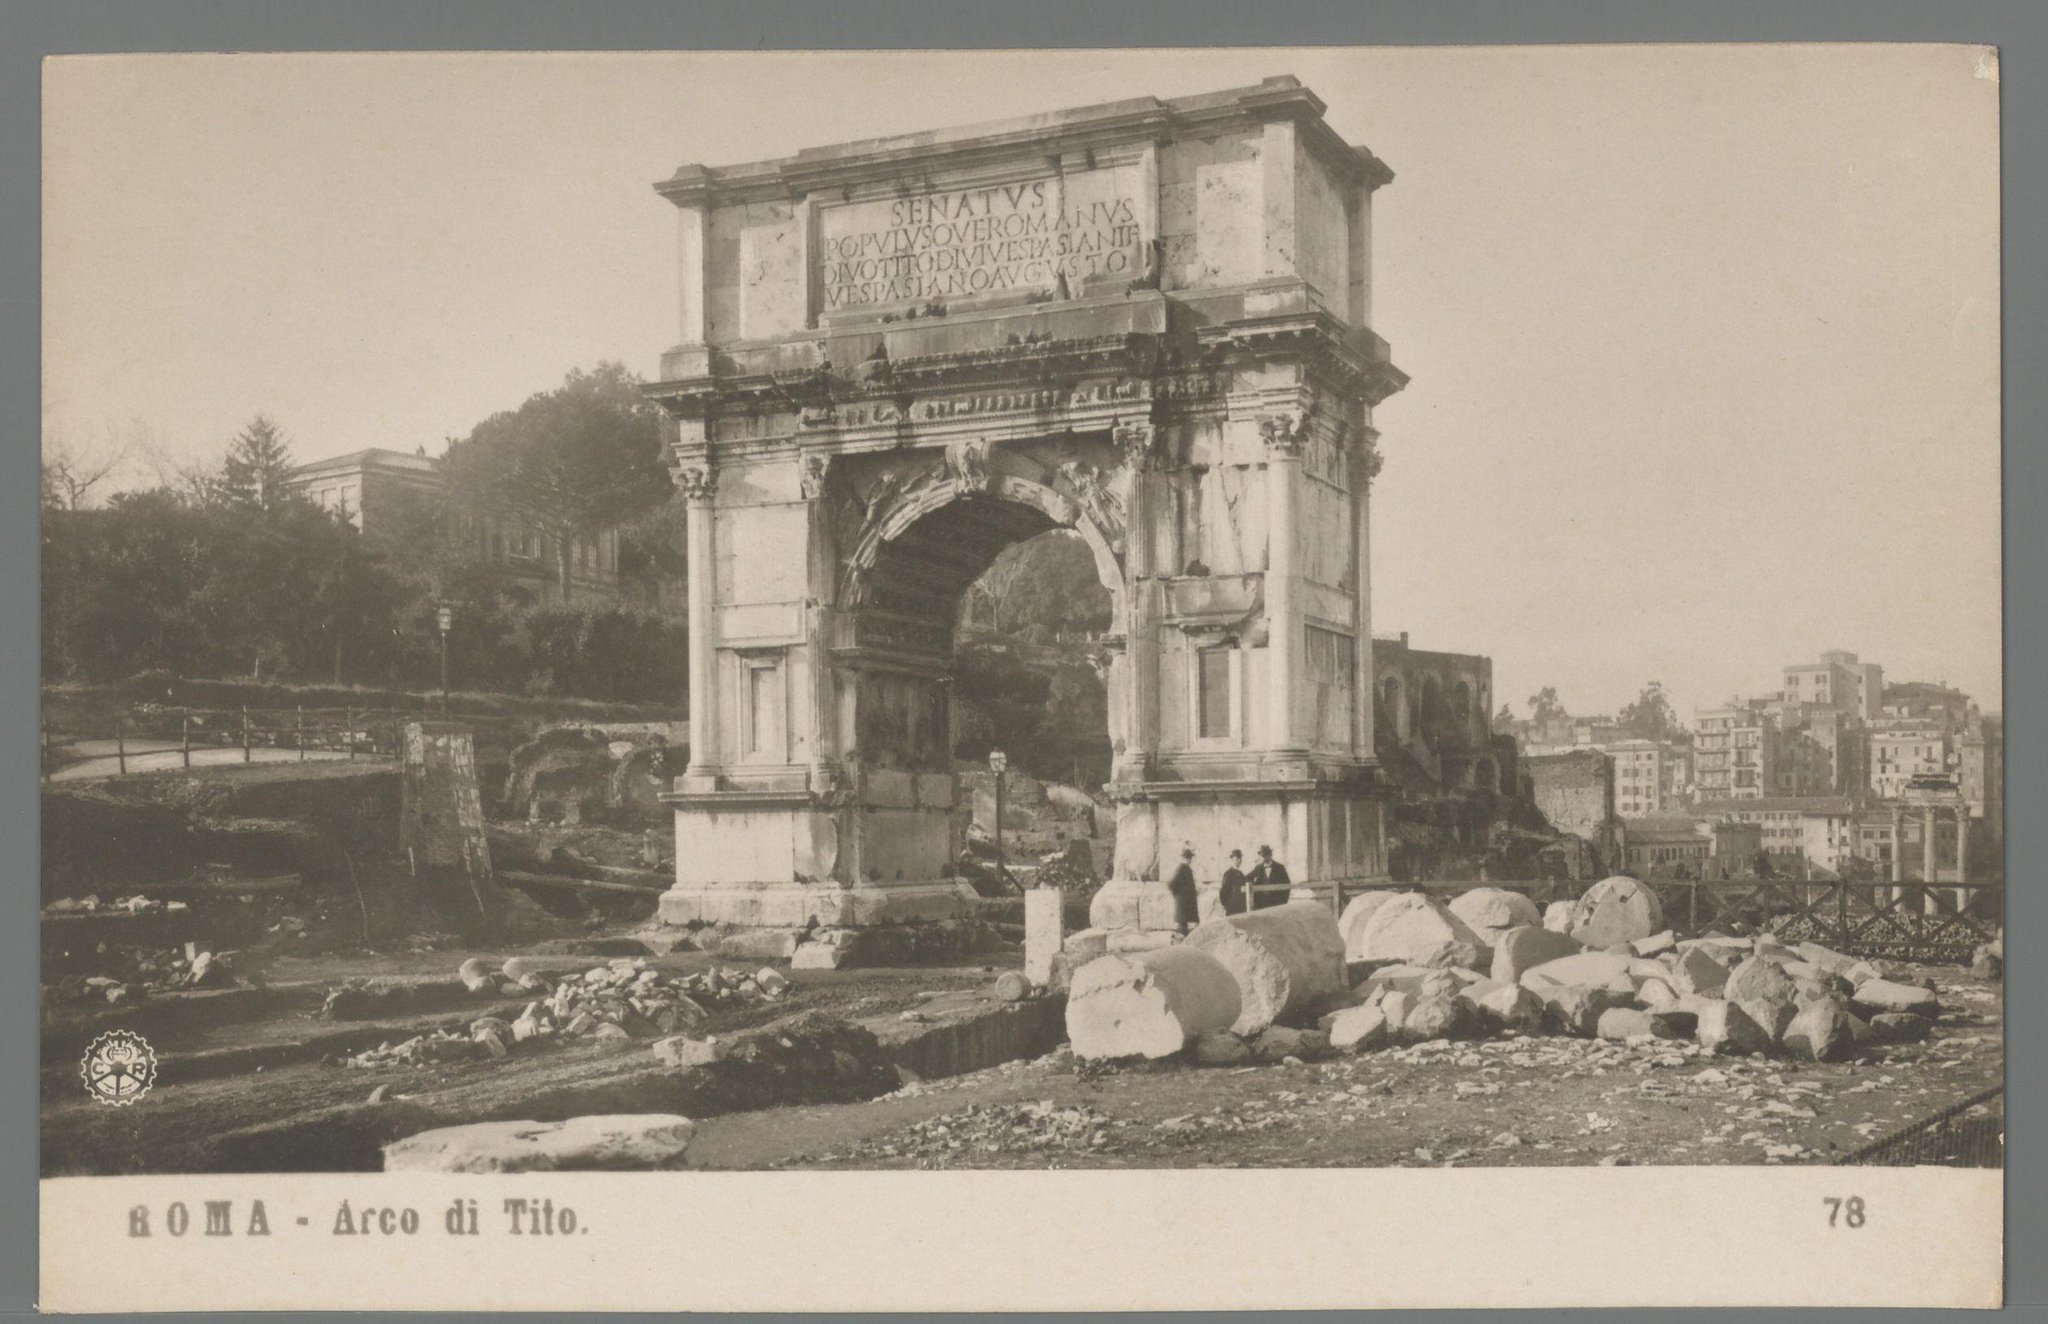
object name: photograph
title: Roma. Arco di Tito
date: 1906-1920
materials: photographic support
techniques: photography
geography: italy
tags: triumphal arch, excavation ~ archaeology, square, place, circus, etc. (+ city(-scape) with figures, staffage)